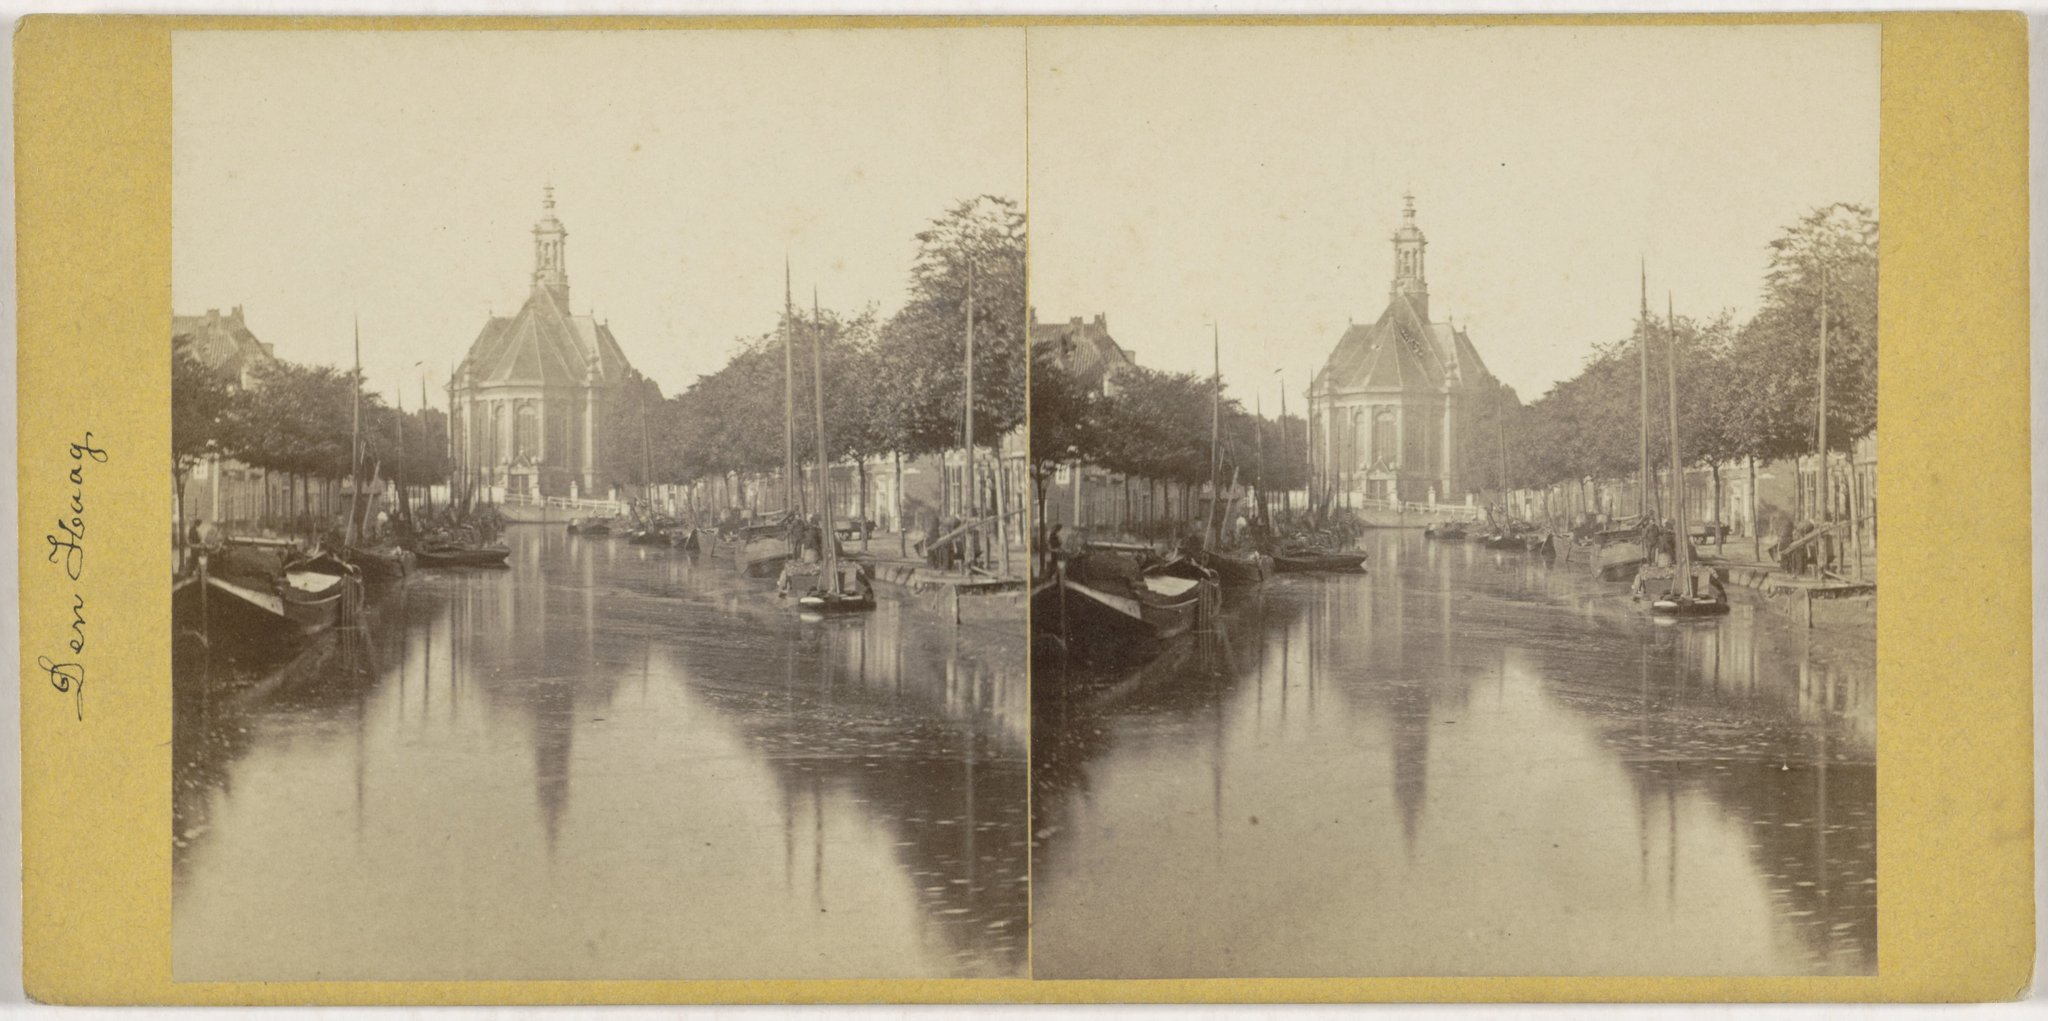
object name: stereograph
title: Nieuwe Kerk, van de Wijnhaven gezien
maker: Anonymous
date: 1852-1863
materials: cardboard, paper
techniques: albumen print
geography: the hague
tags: parts of church exterior and annexes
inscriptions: inscription: ‘50’